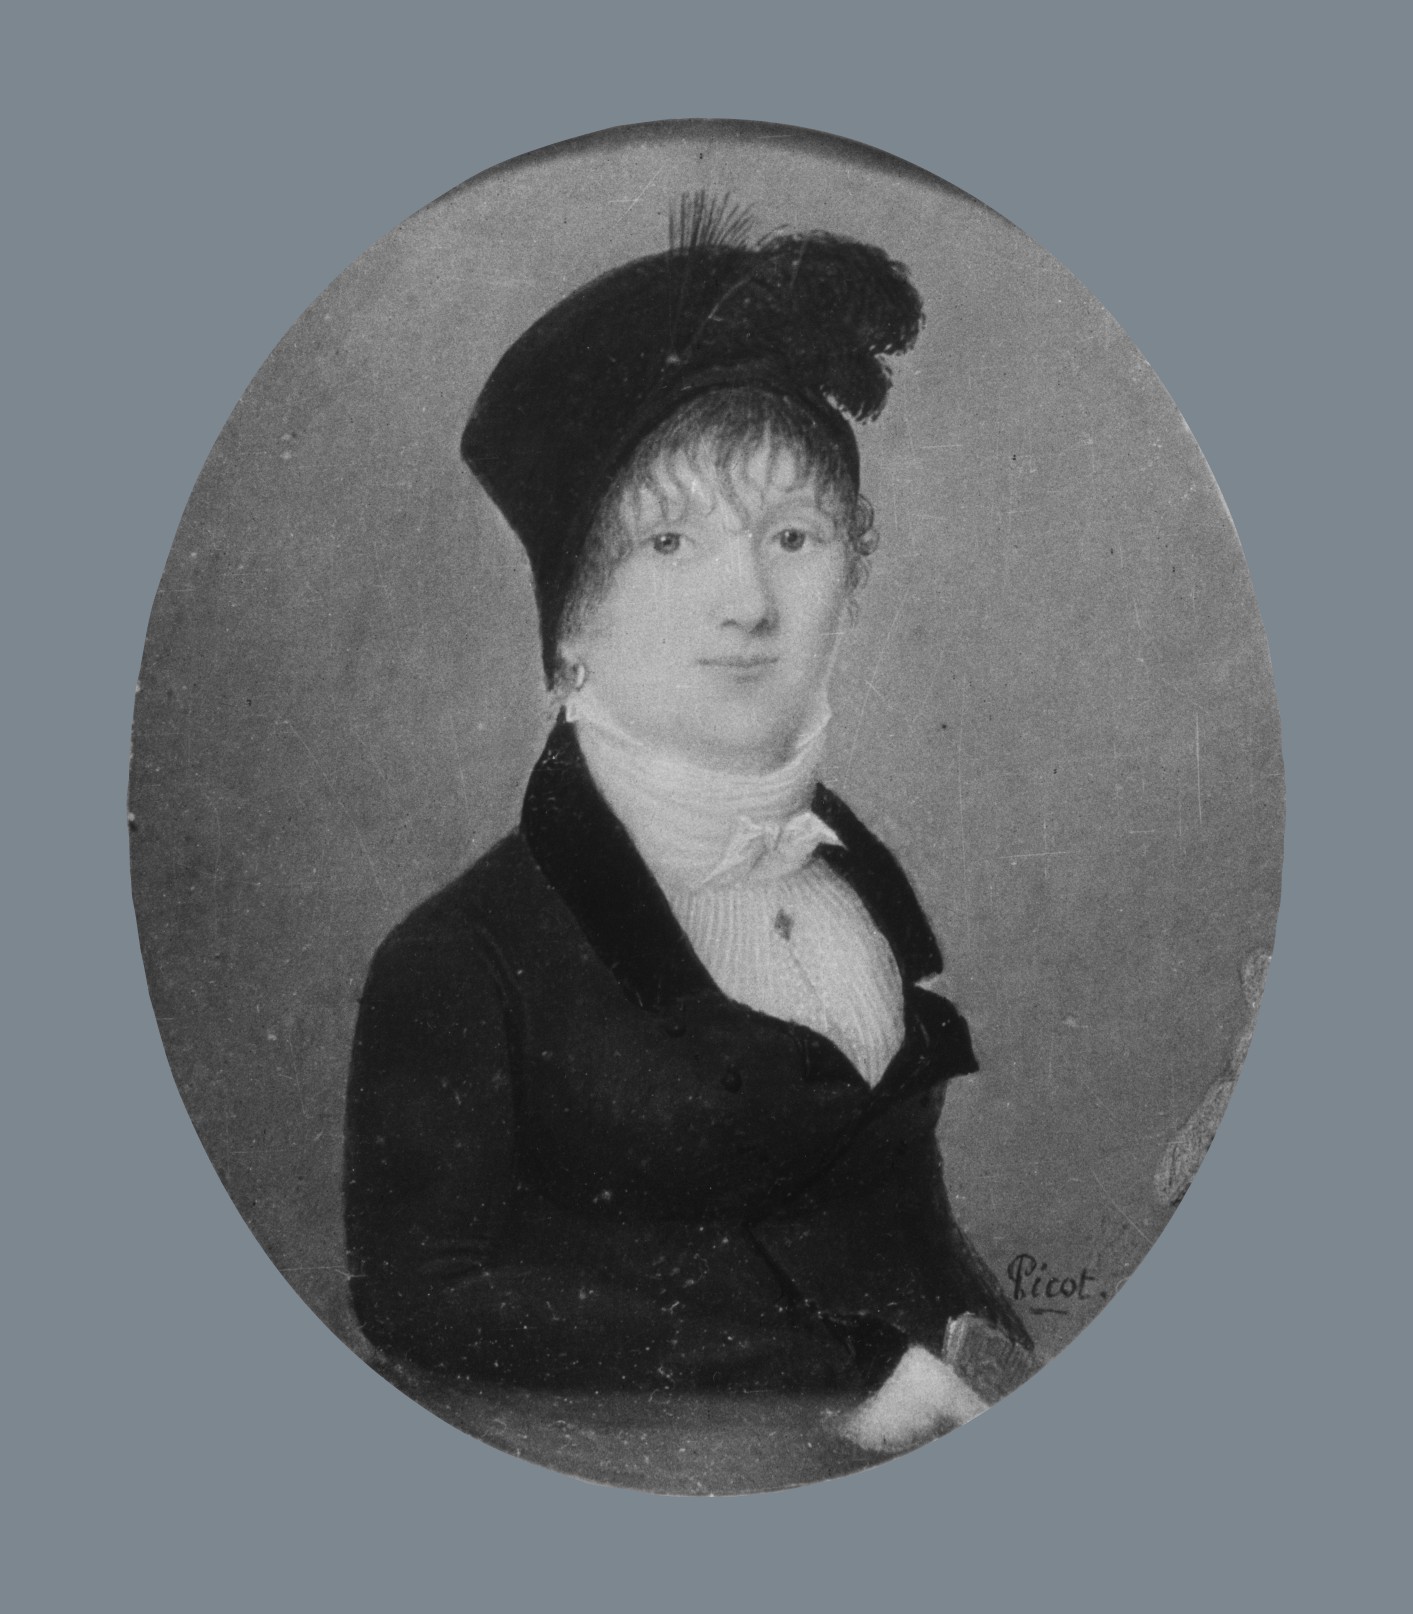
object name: painting, miniature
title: Portrait of a Lady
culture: american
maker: joseph-pierre picot de limoelan de cloriviere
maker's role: artist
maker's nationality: american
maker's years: 1768-1826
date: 1808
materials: ivory, watercolor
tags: portraits,women